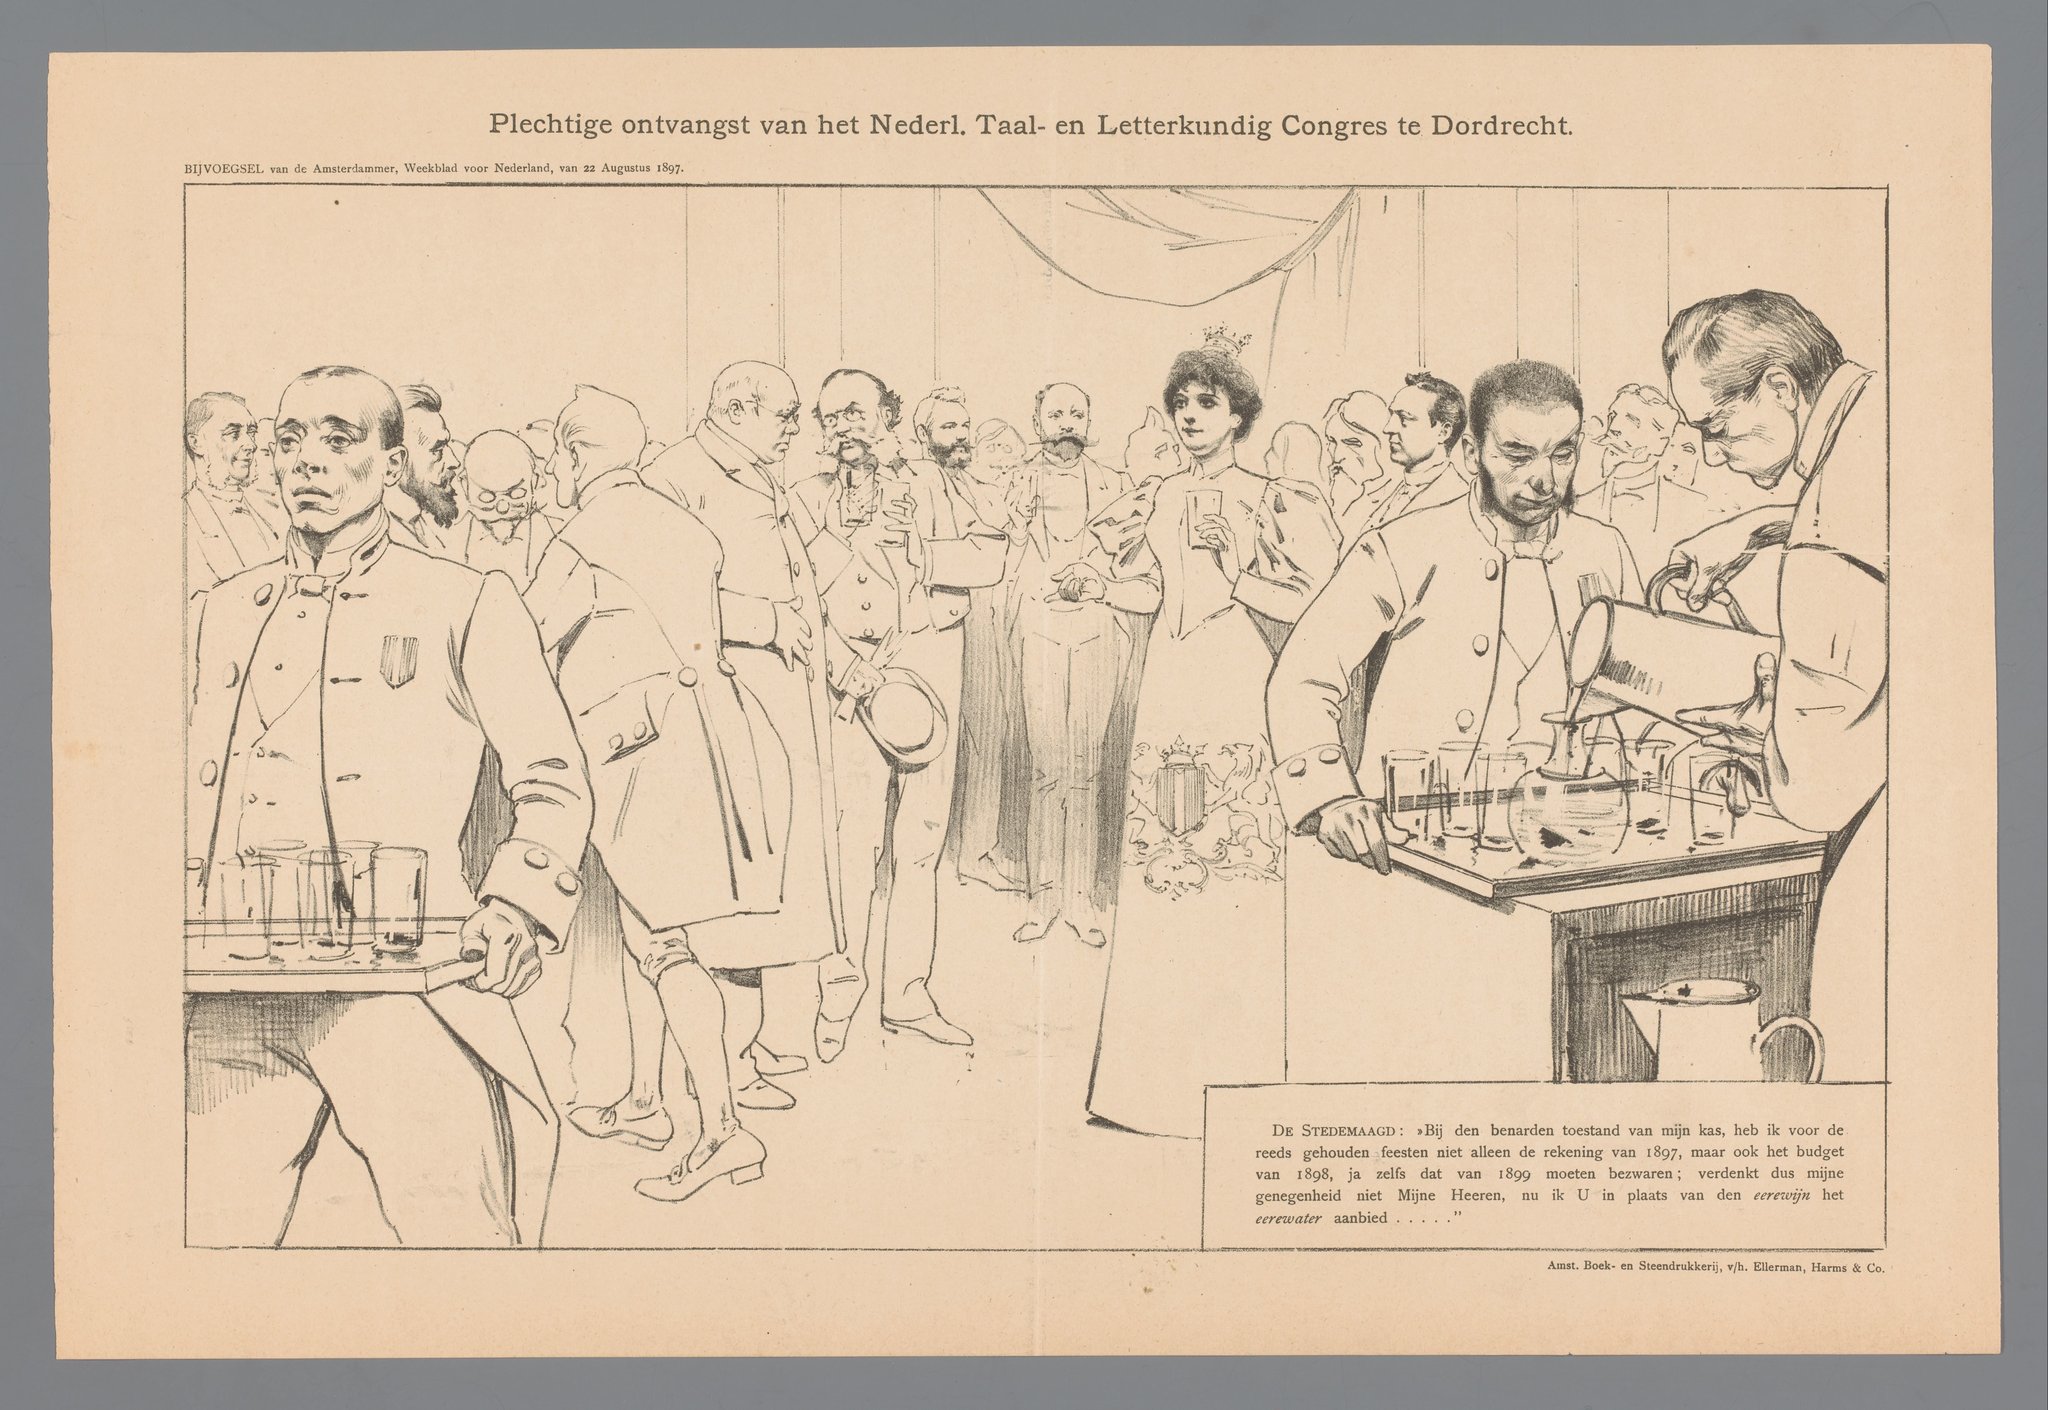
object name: cartoon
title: Plechtige ontvangst van het Nederl. Taal- en Letterkundig congres te Dordrecht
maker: johan braakensiek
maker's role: draughtsman, print maker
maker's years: 1858-1940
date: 1897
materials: paper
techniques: lithograph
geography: amsterdam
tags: politician, e.g. party leader, drinking, dordrecht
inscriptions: date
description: Prent uit het bijvoegsel van: De Amsterdammer. Weekblad voor Nederland, 22 augustus 1897.